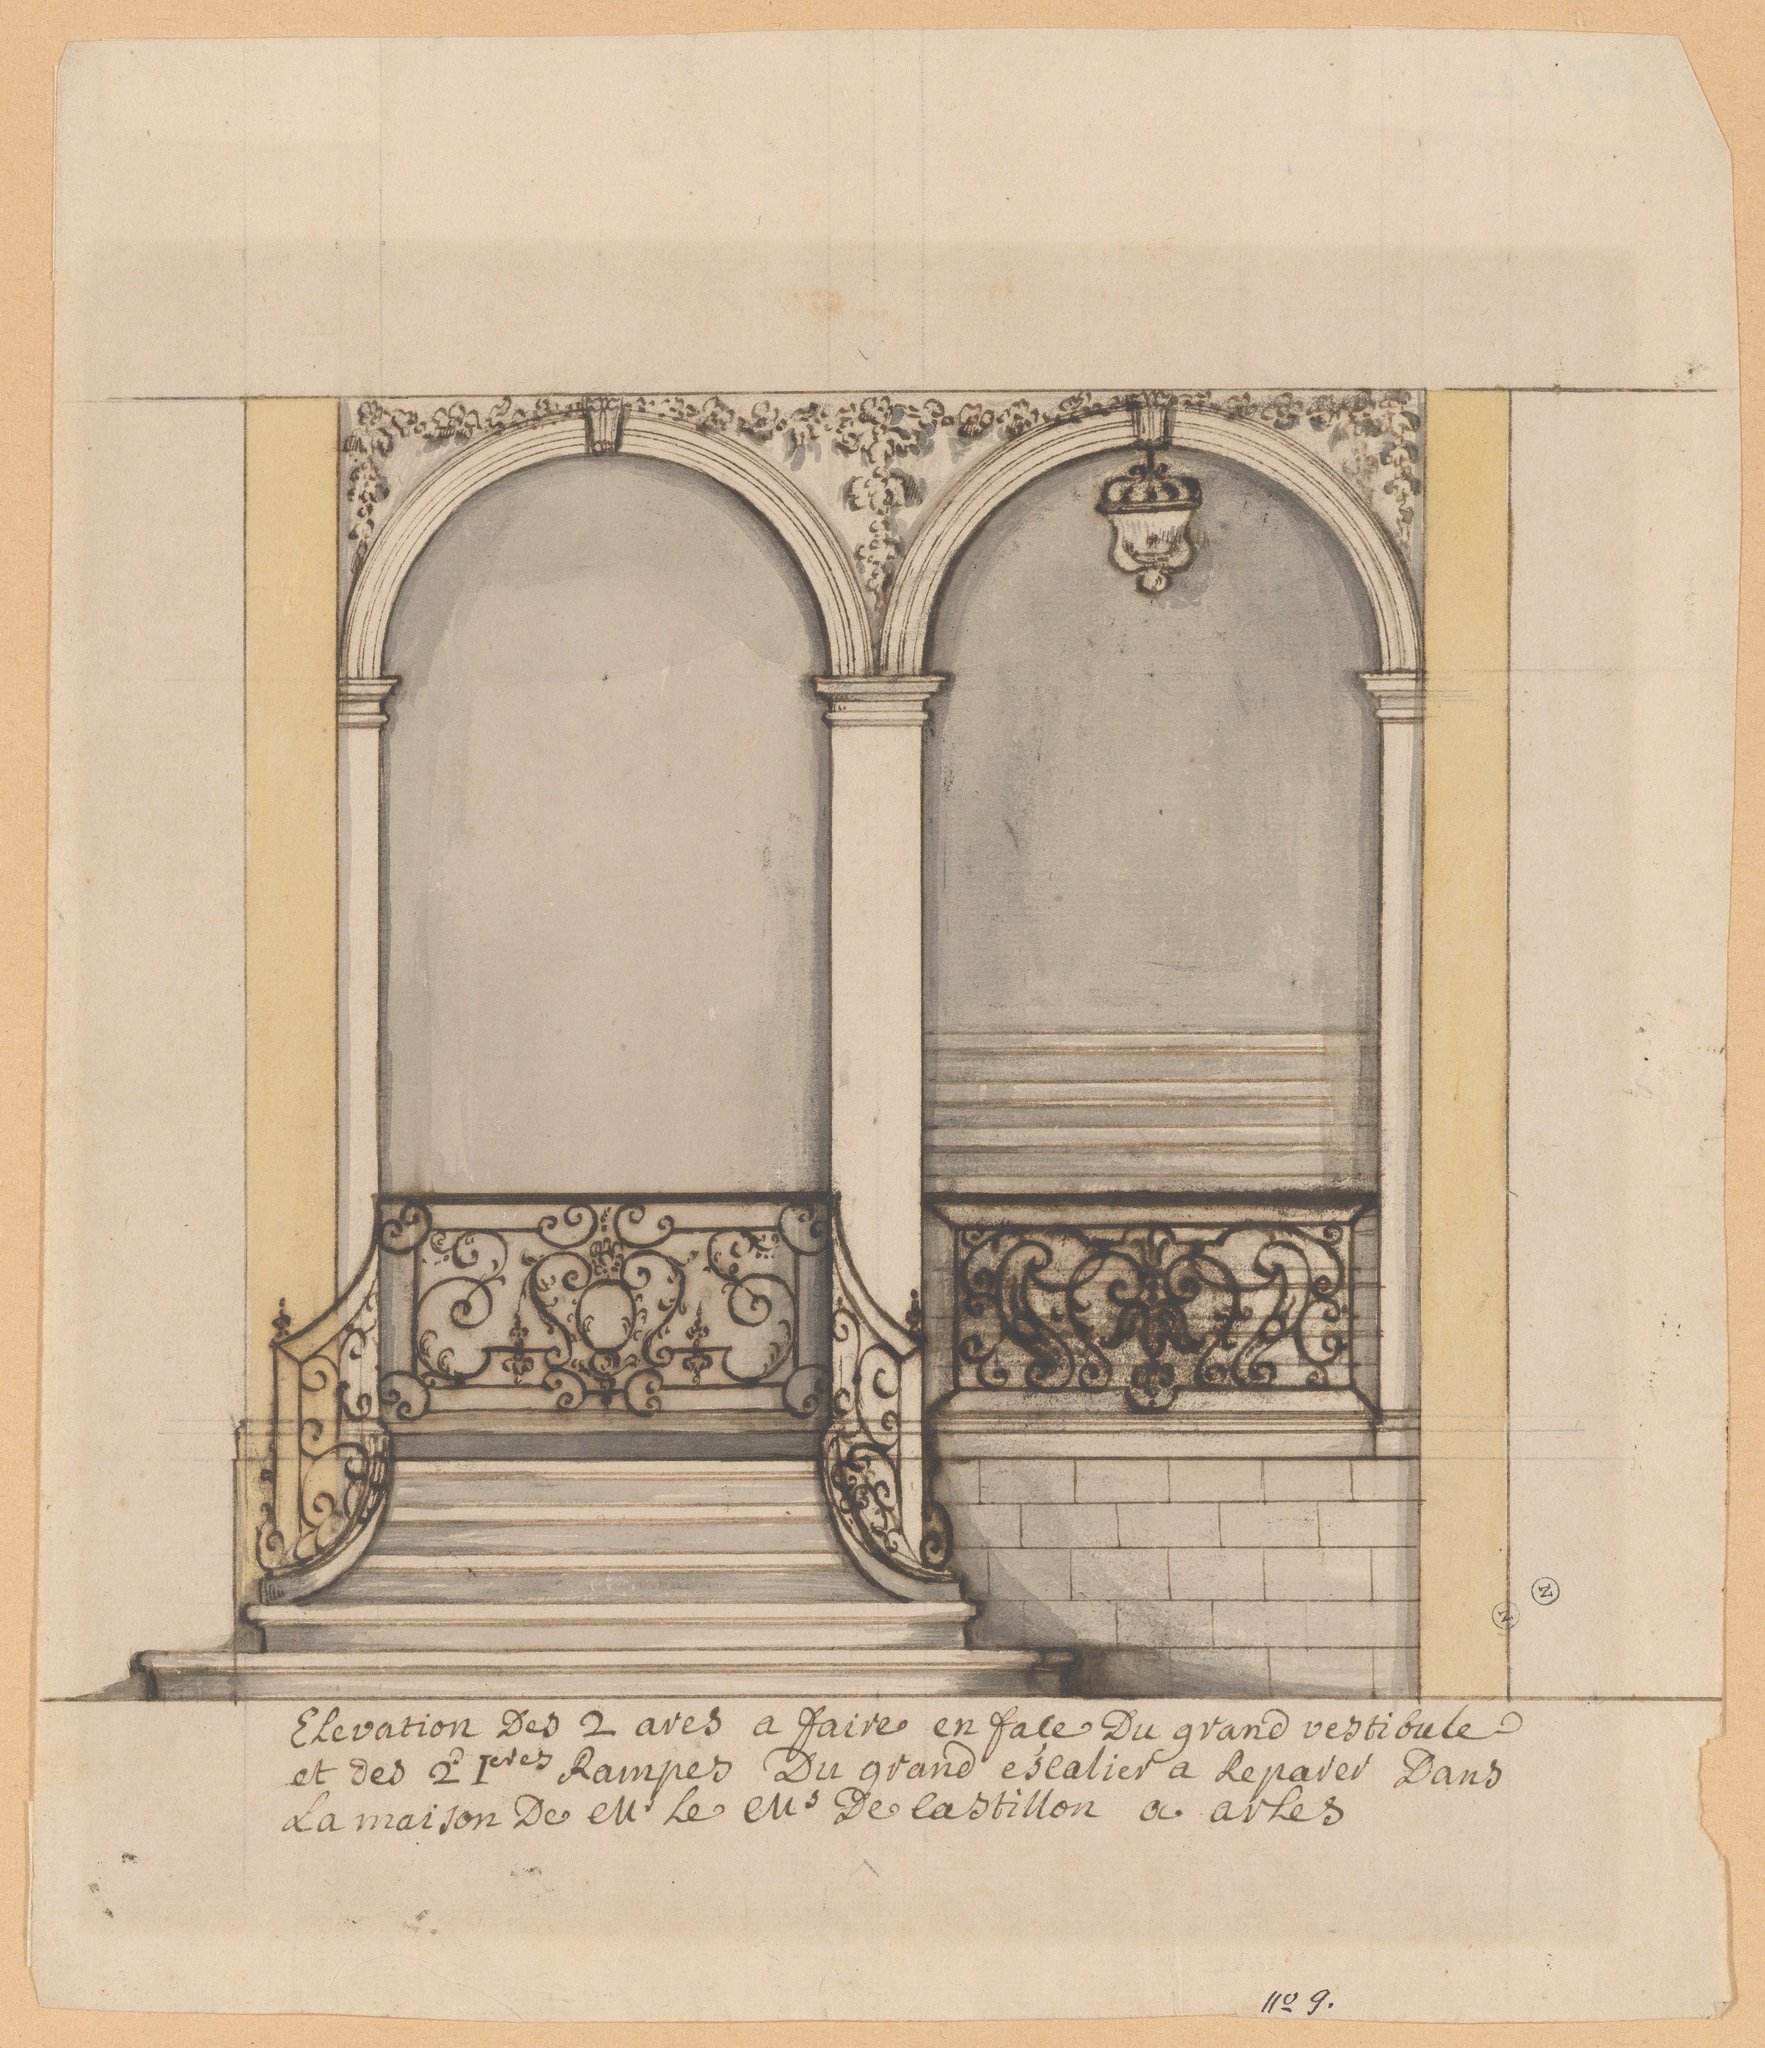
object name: drawing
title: Elevation for a stairway and a second en suite drawing (unmatted): design for ironwork balustrade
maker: anonymous, french, 18th century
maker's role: artist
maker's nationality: french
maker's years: 1700-1800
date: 1700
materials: ink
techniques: pen, wash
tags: architecture,stairs